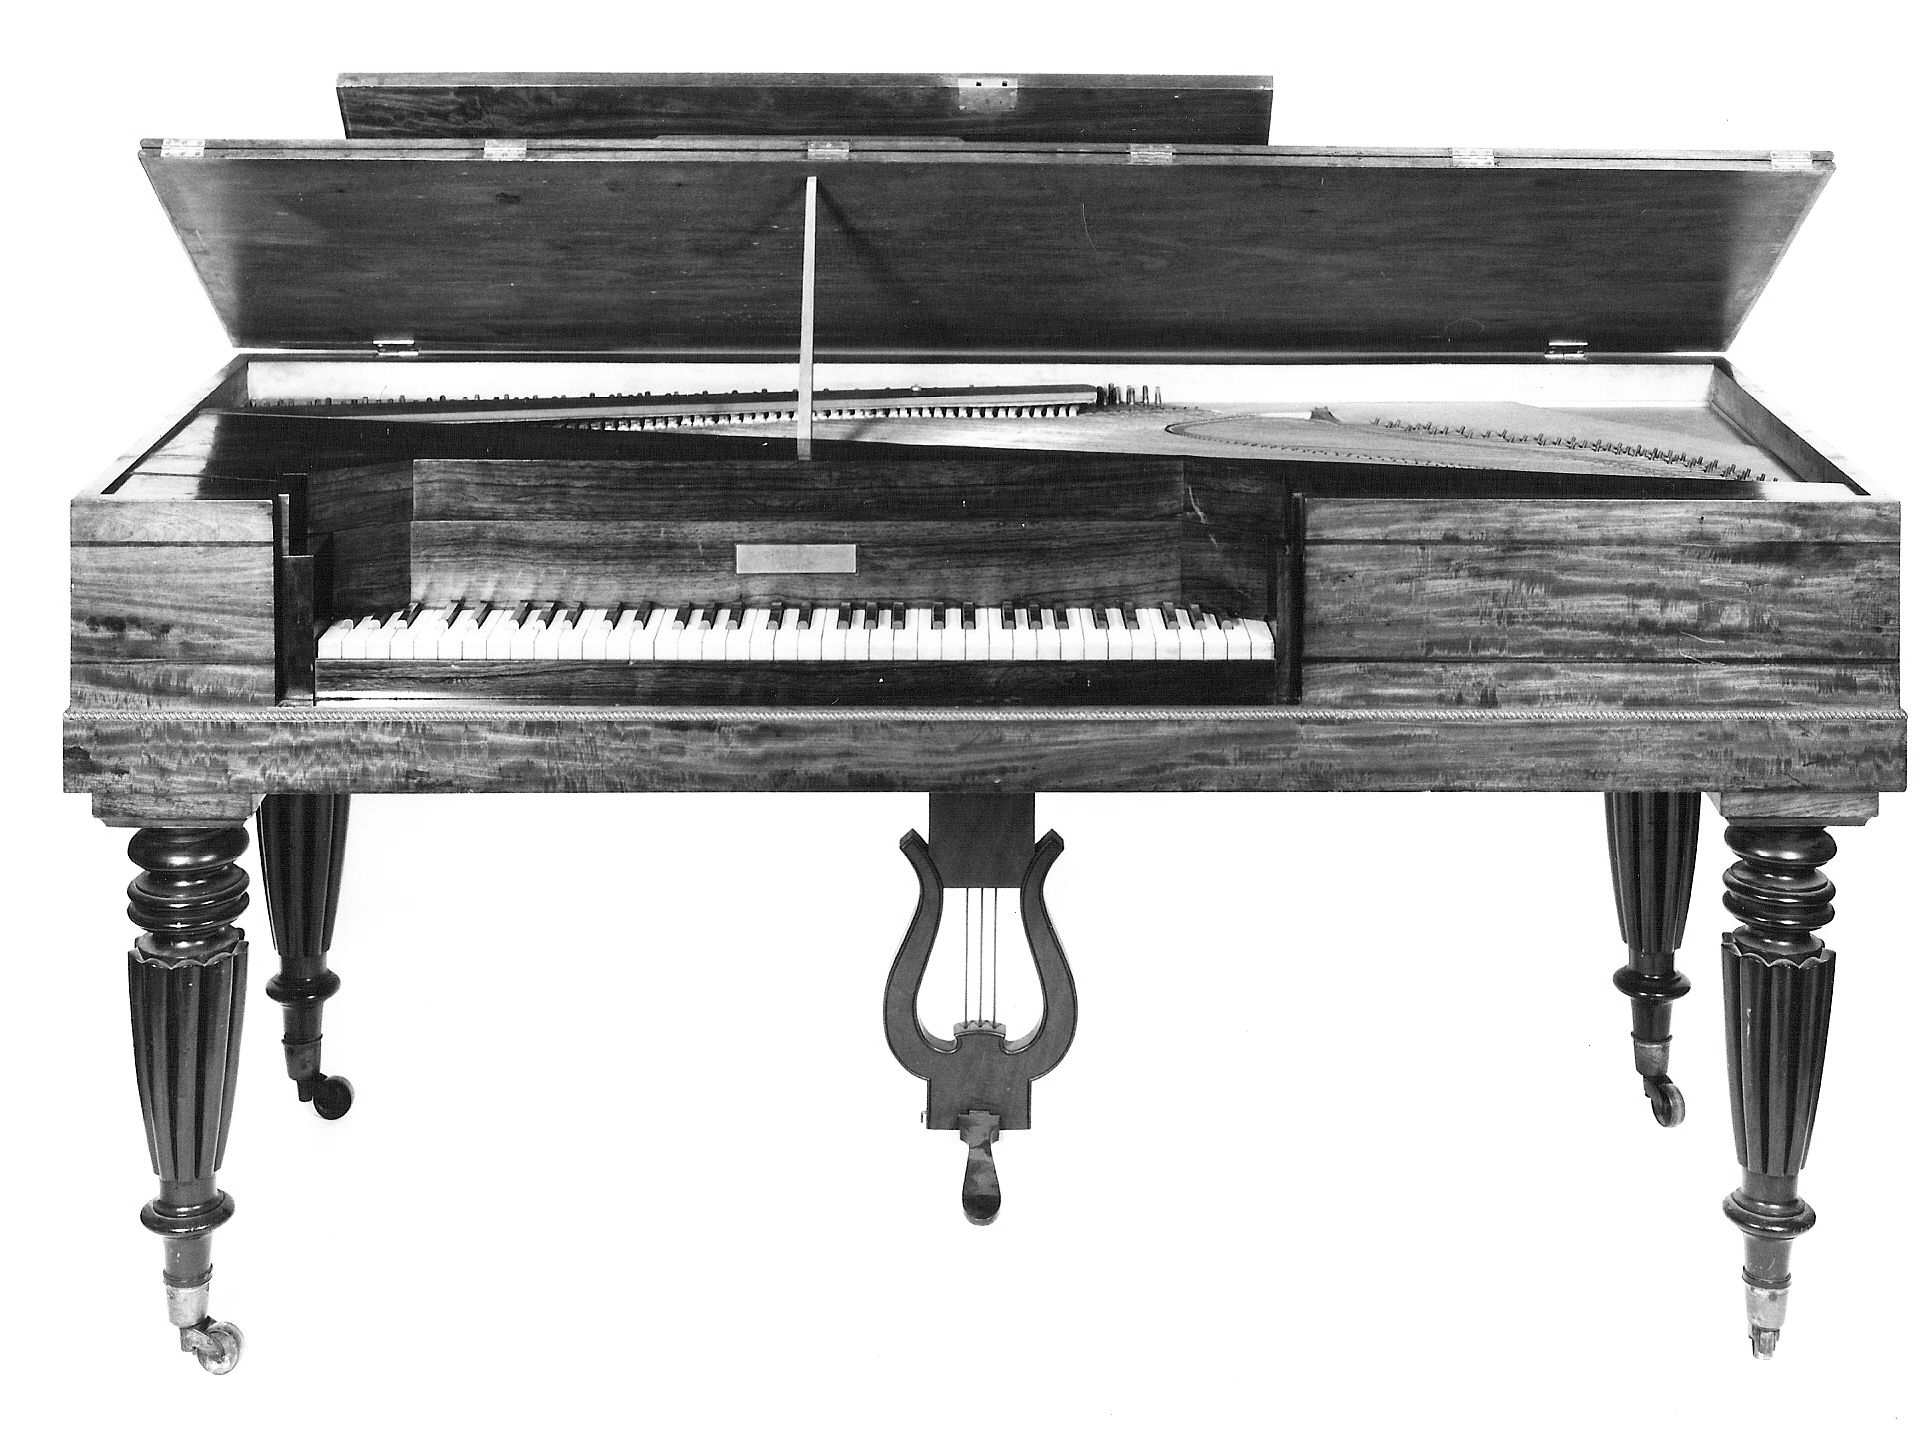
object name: square piano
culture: american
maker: jonas chickering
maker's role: maker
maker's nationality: american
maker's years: 1798-1853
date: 1829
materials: wood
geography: united states